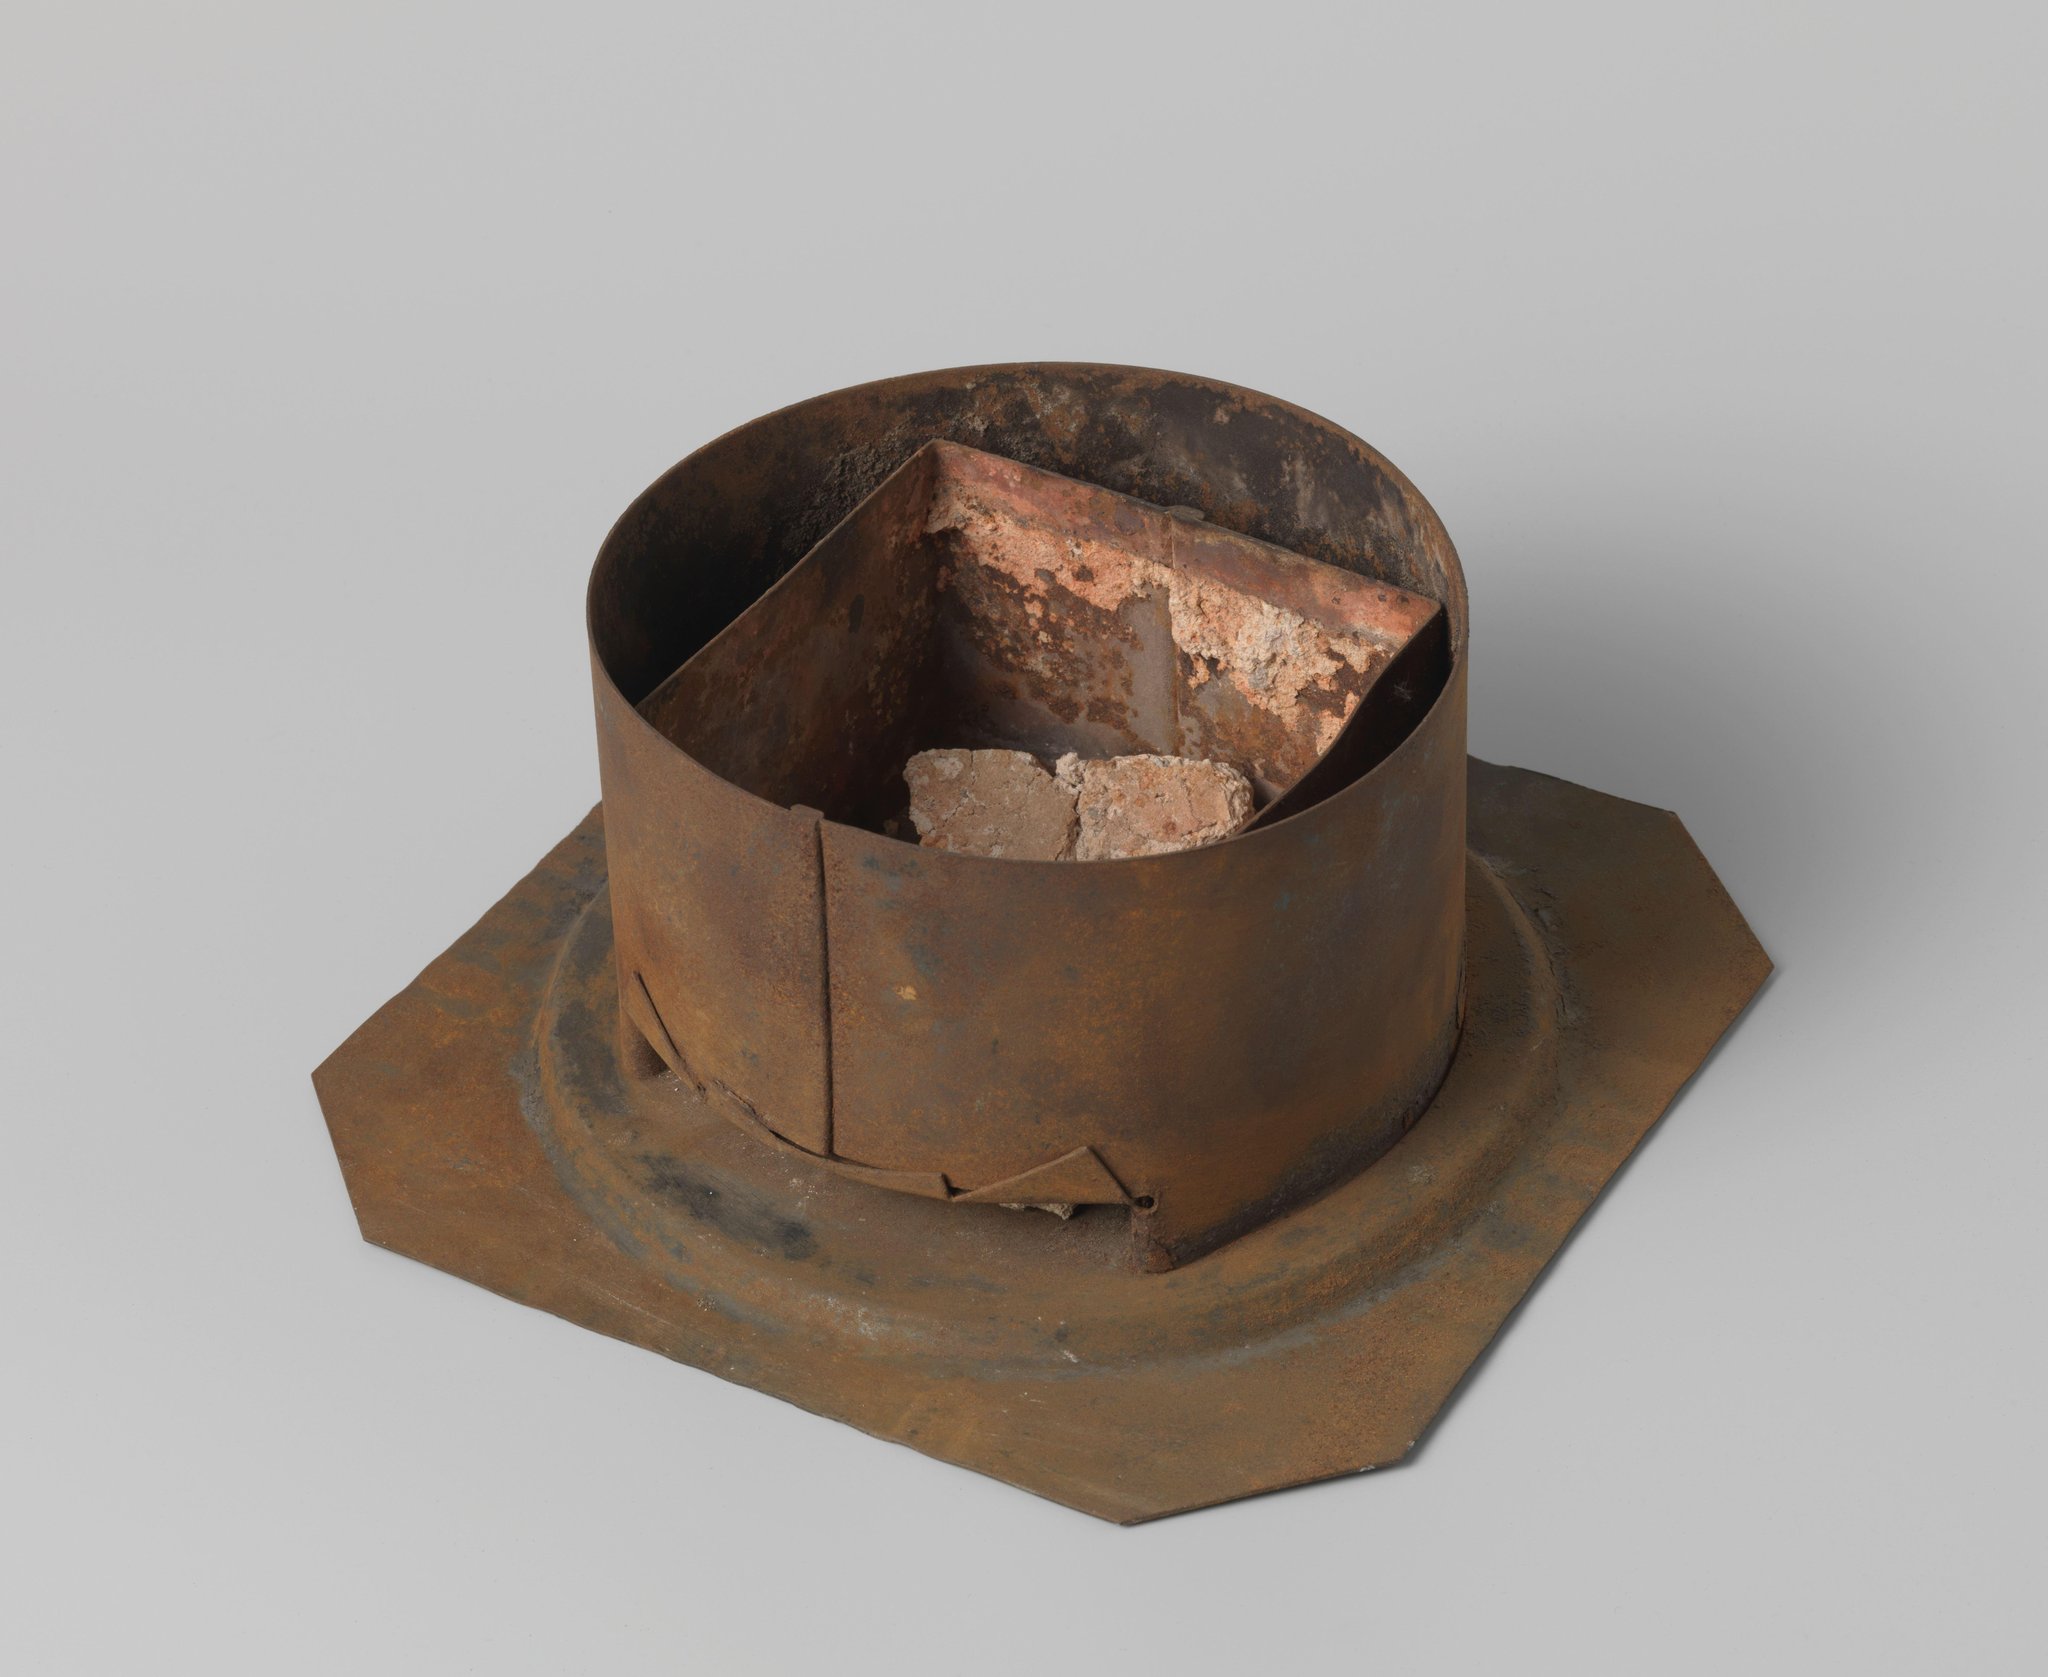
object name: stove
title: Noodkacheltje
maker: j.c. nienaber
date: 1940-1945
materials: cement, iron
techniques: construction, forging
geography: amsterdam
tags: netherlands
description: Op een vierkante ijzeren plaat met schuin afgesneden hoeken staat een ronde ijzeren bak, waarin een vierkante bak met cementen binnenkant die voor het grootste deel verdwenen is. Aan één zijde aan de voet een langwerpige opening, in de bodem drie opening die samen driekwart van een cirkel vormen.